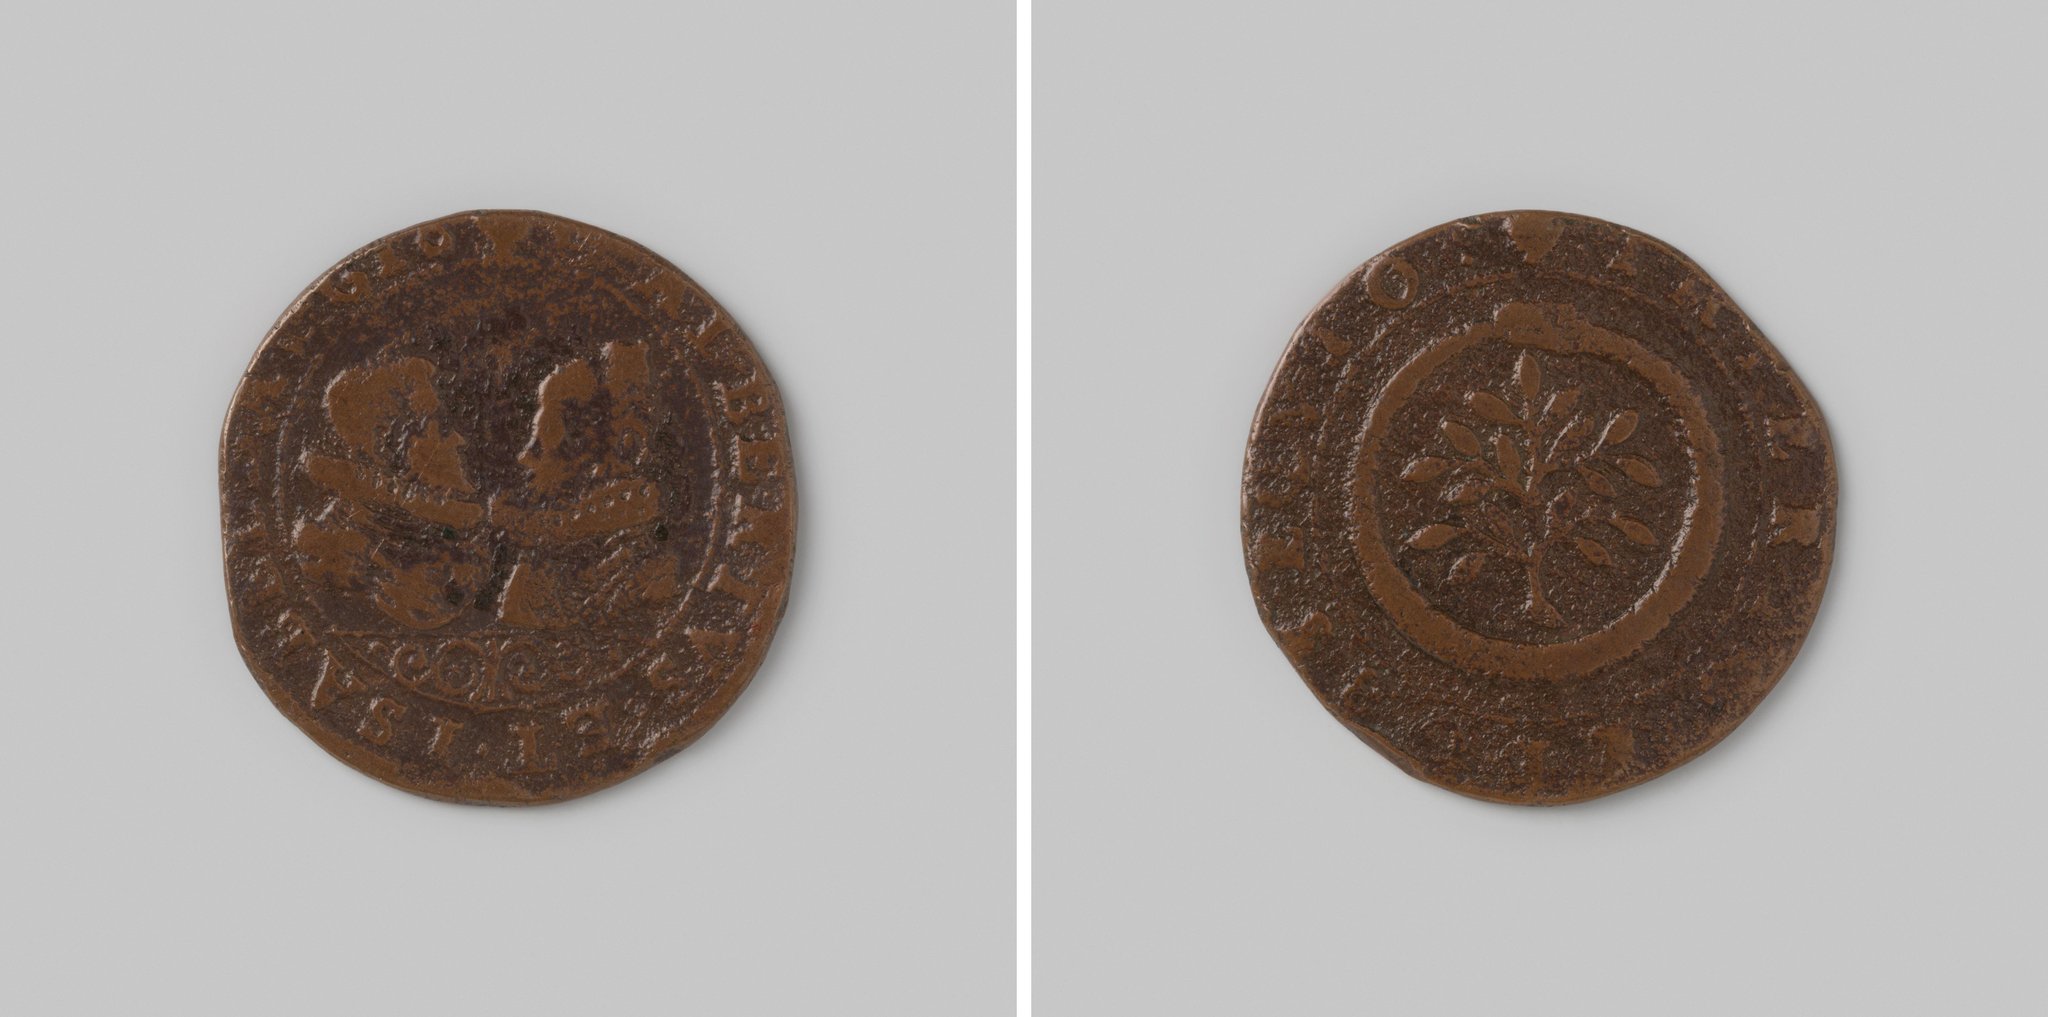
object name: history medal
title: Rekenpenning uit Antwerpen op de veldtocht van Mendoça 1614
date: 1614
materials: copper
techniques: striking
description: Koperen penning, op de voorzijde de elkaar toegewende borstbeelden van Albert en Isabella met omschrift, op de keerzijde een tak binnen een slangenrond, met omschrift.